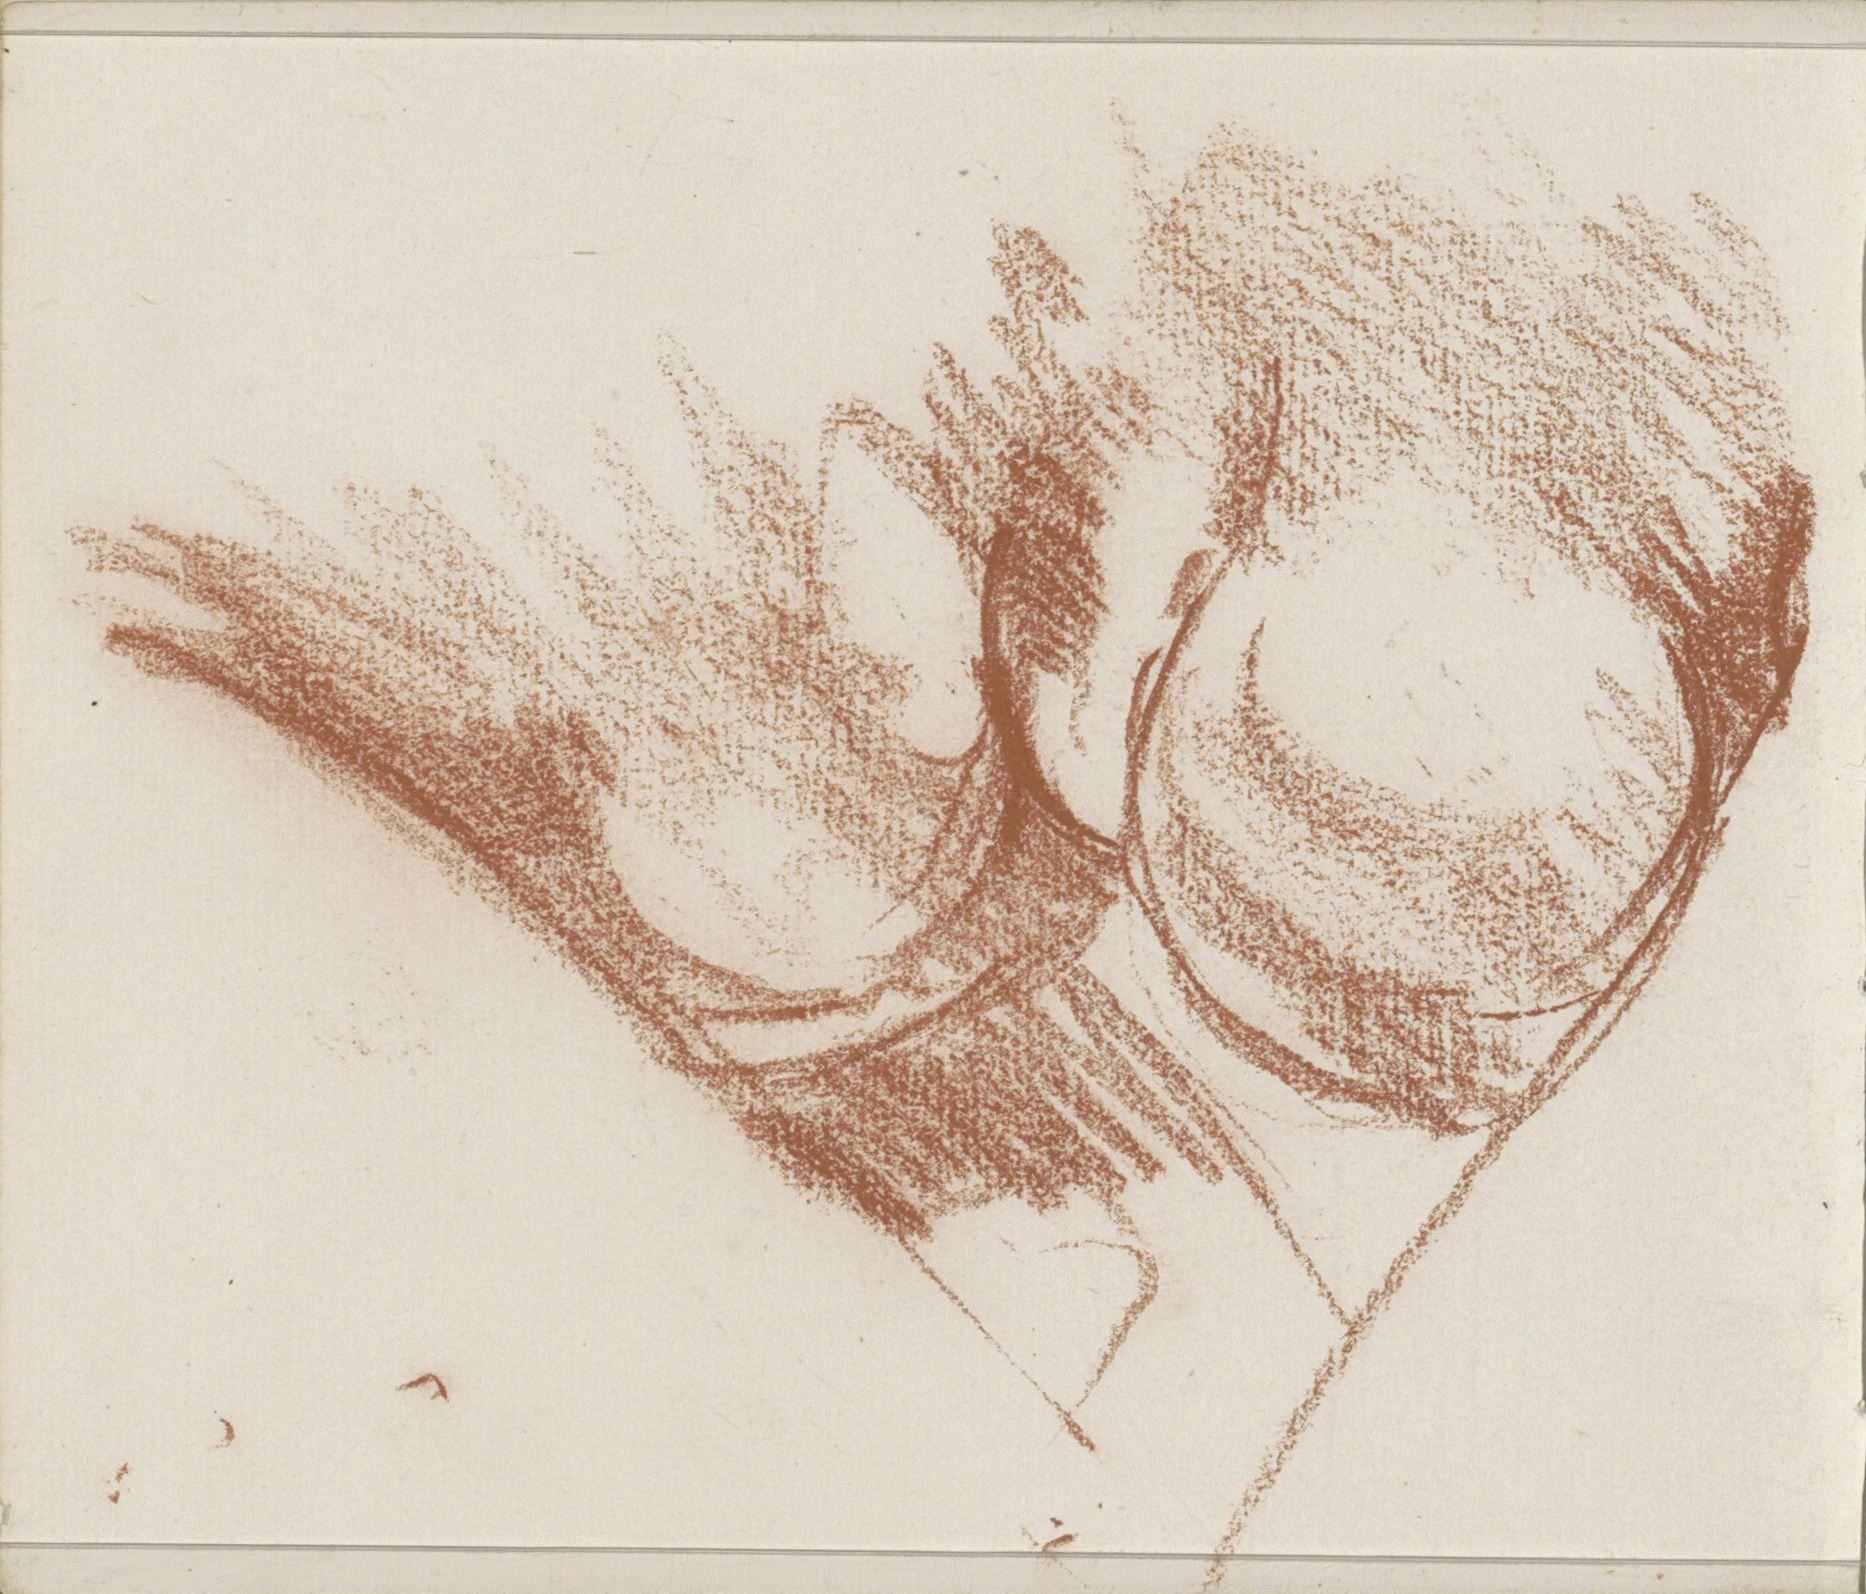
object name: sketchbook leaf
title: Studie, mogelijk een stilleven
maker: willem witsen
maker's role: draughtsman, painter, print maker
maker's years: 1860-1923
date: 1915-1920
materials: chalk, paper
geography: amsterdam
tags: still life of related objects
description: Blad 5 verso uit een schetsboek met 12 bladen.